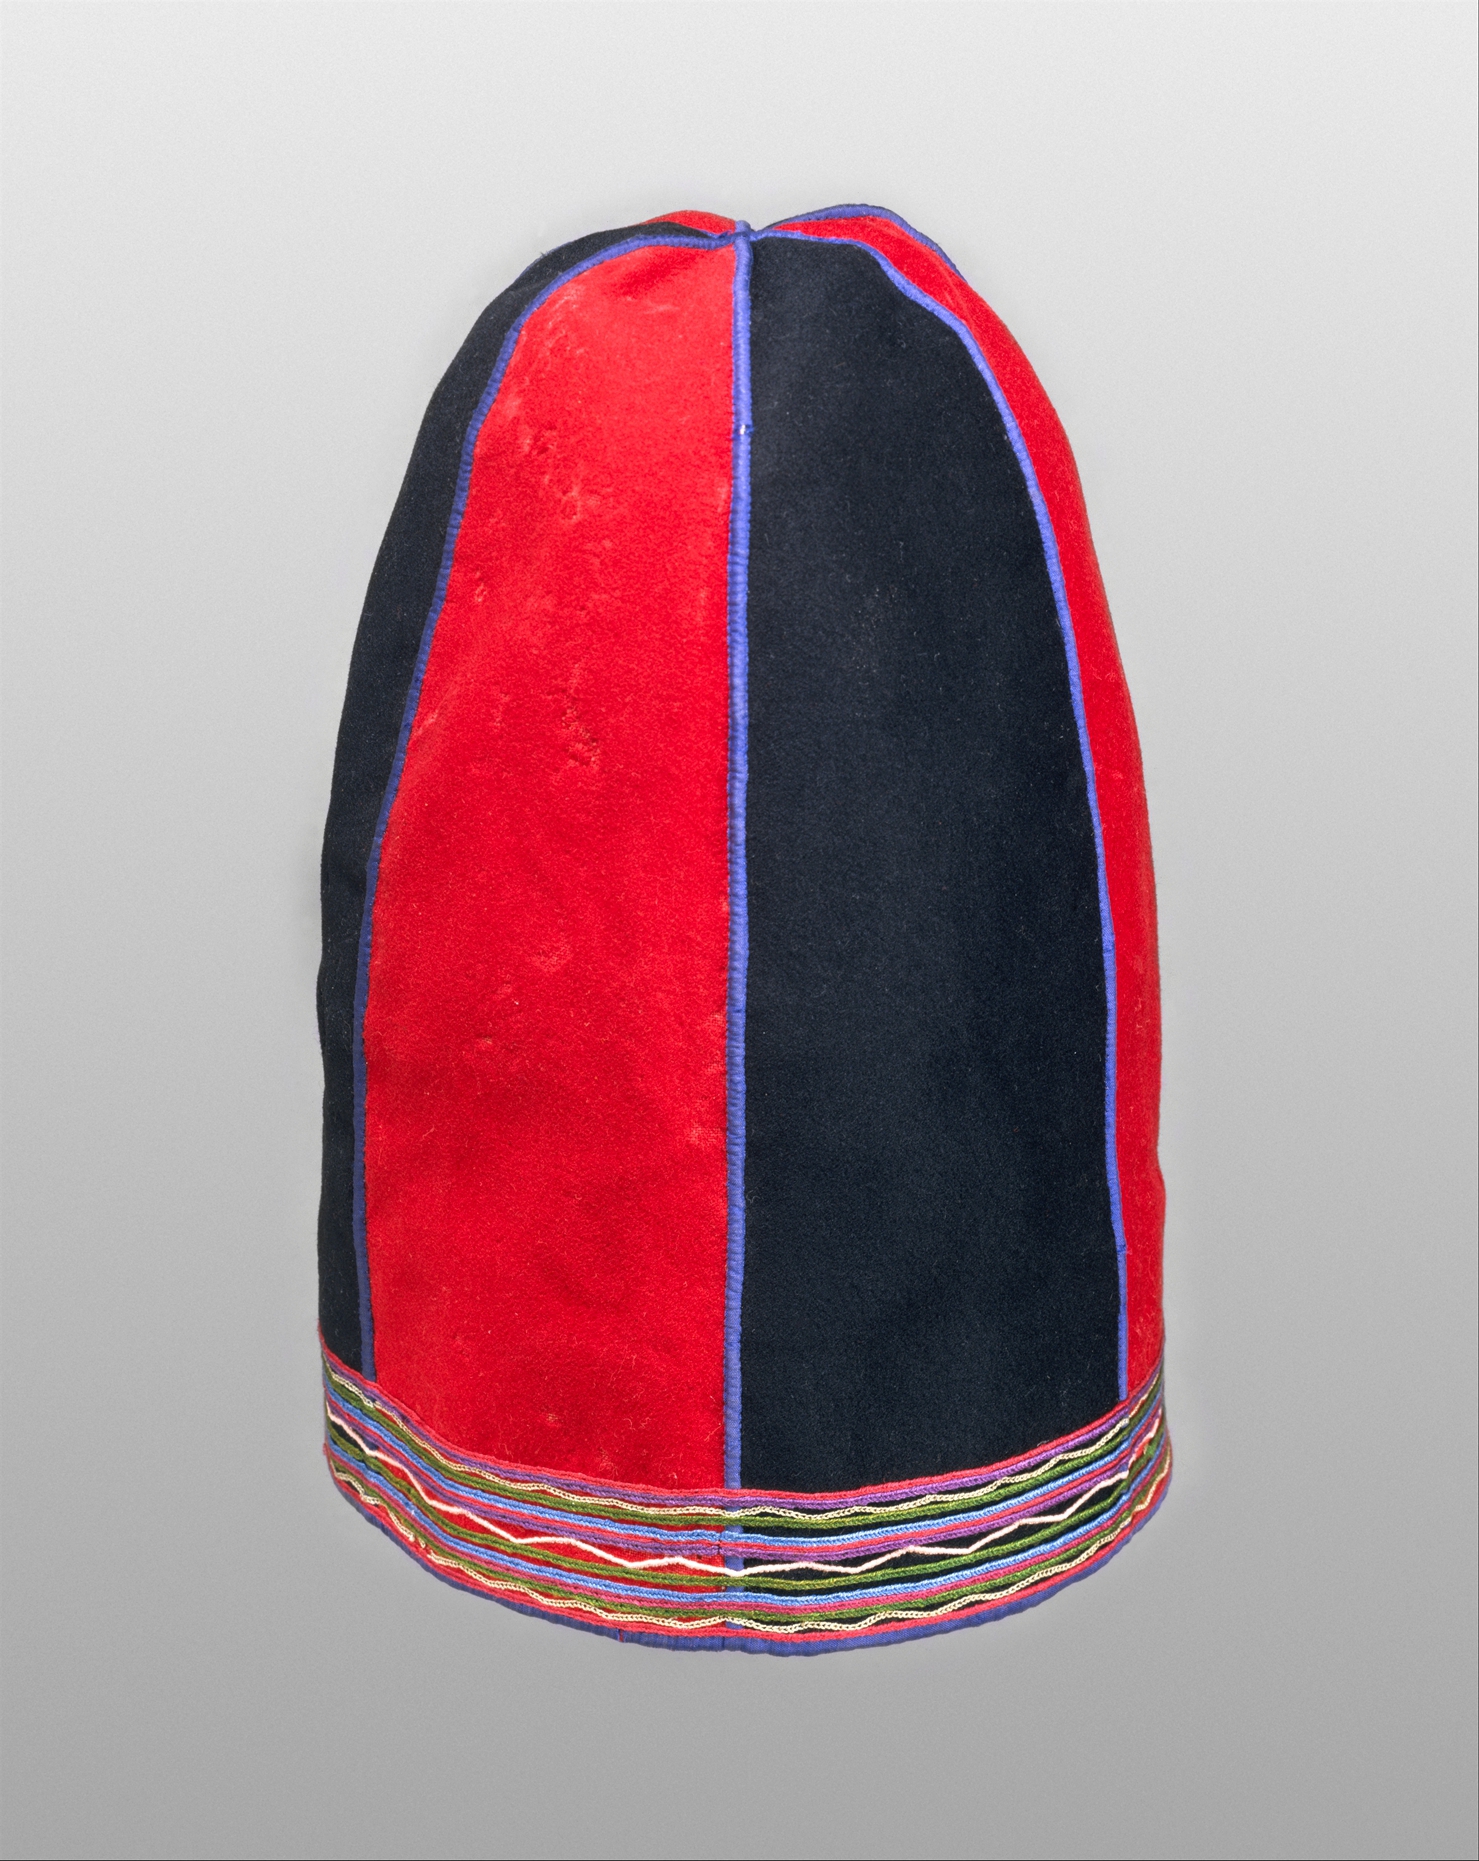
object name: hat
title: Cap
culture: naskapi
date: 1850-1860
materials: silk, wool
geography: canada